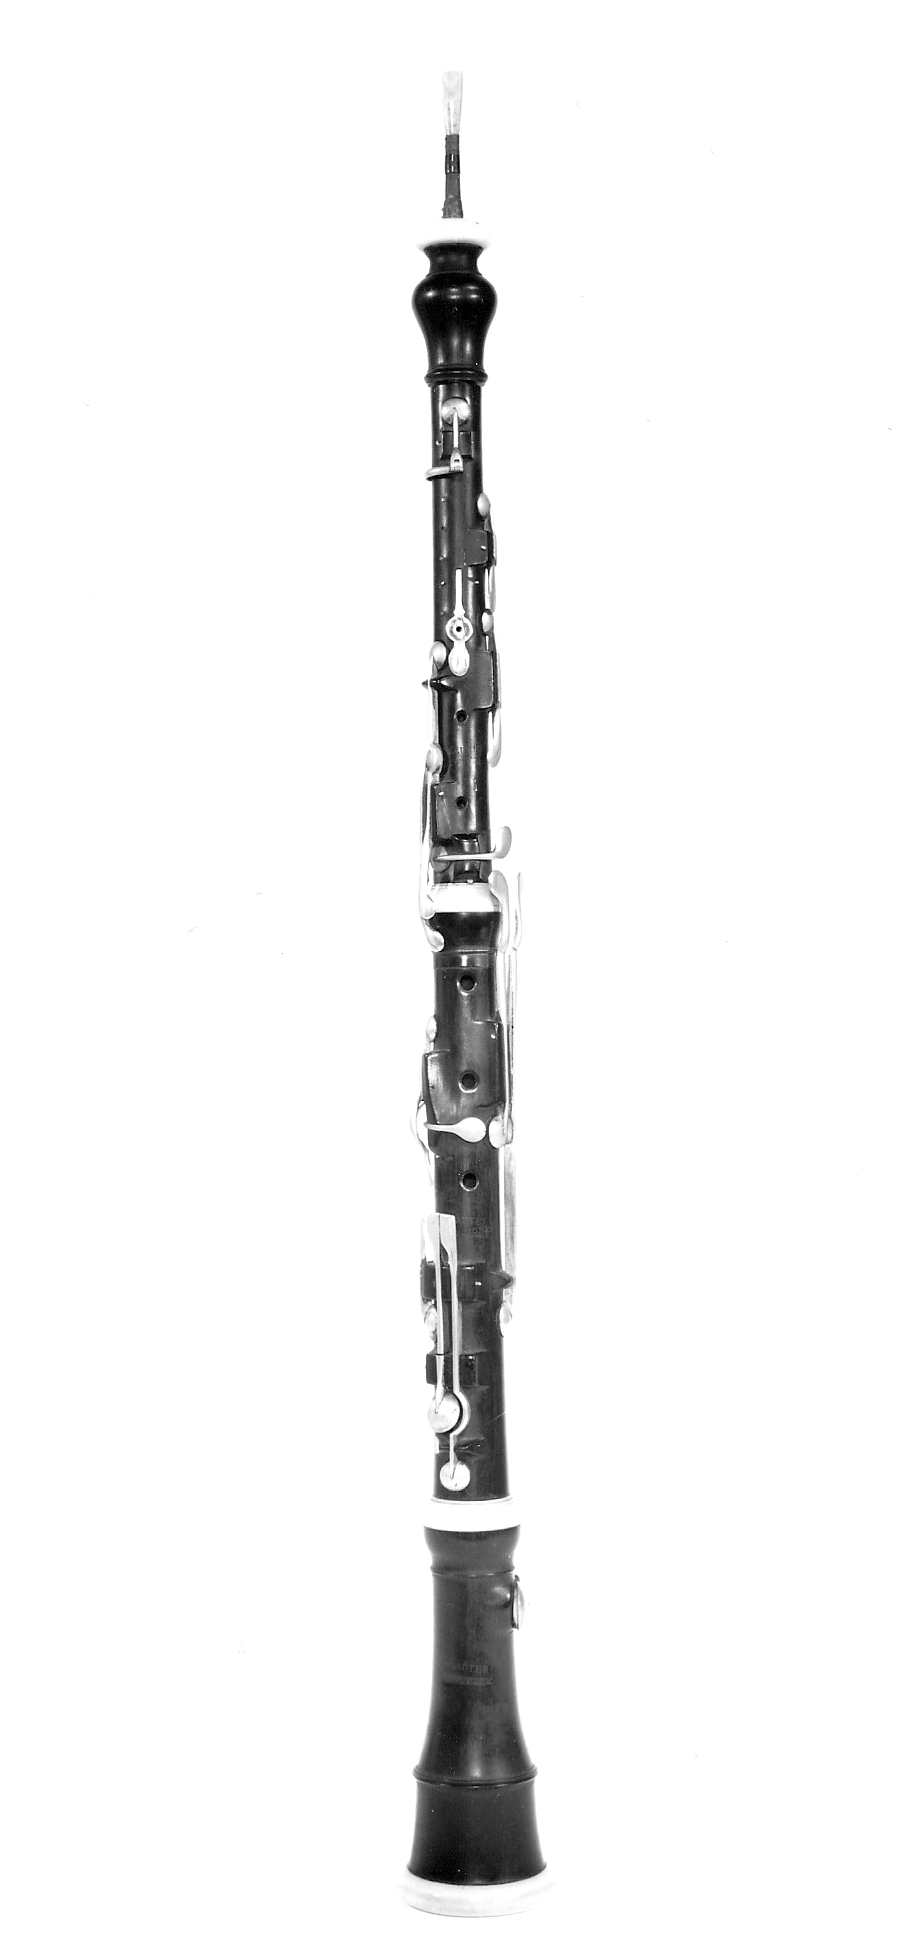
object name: oboe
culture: german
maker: franz lauter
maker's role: artist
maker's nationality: german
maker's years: 1845-1885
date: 1855-1860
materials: brass, horn, ivory, metal, wood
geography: germany